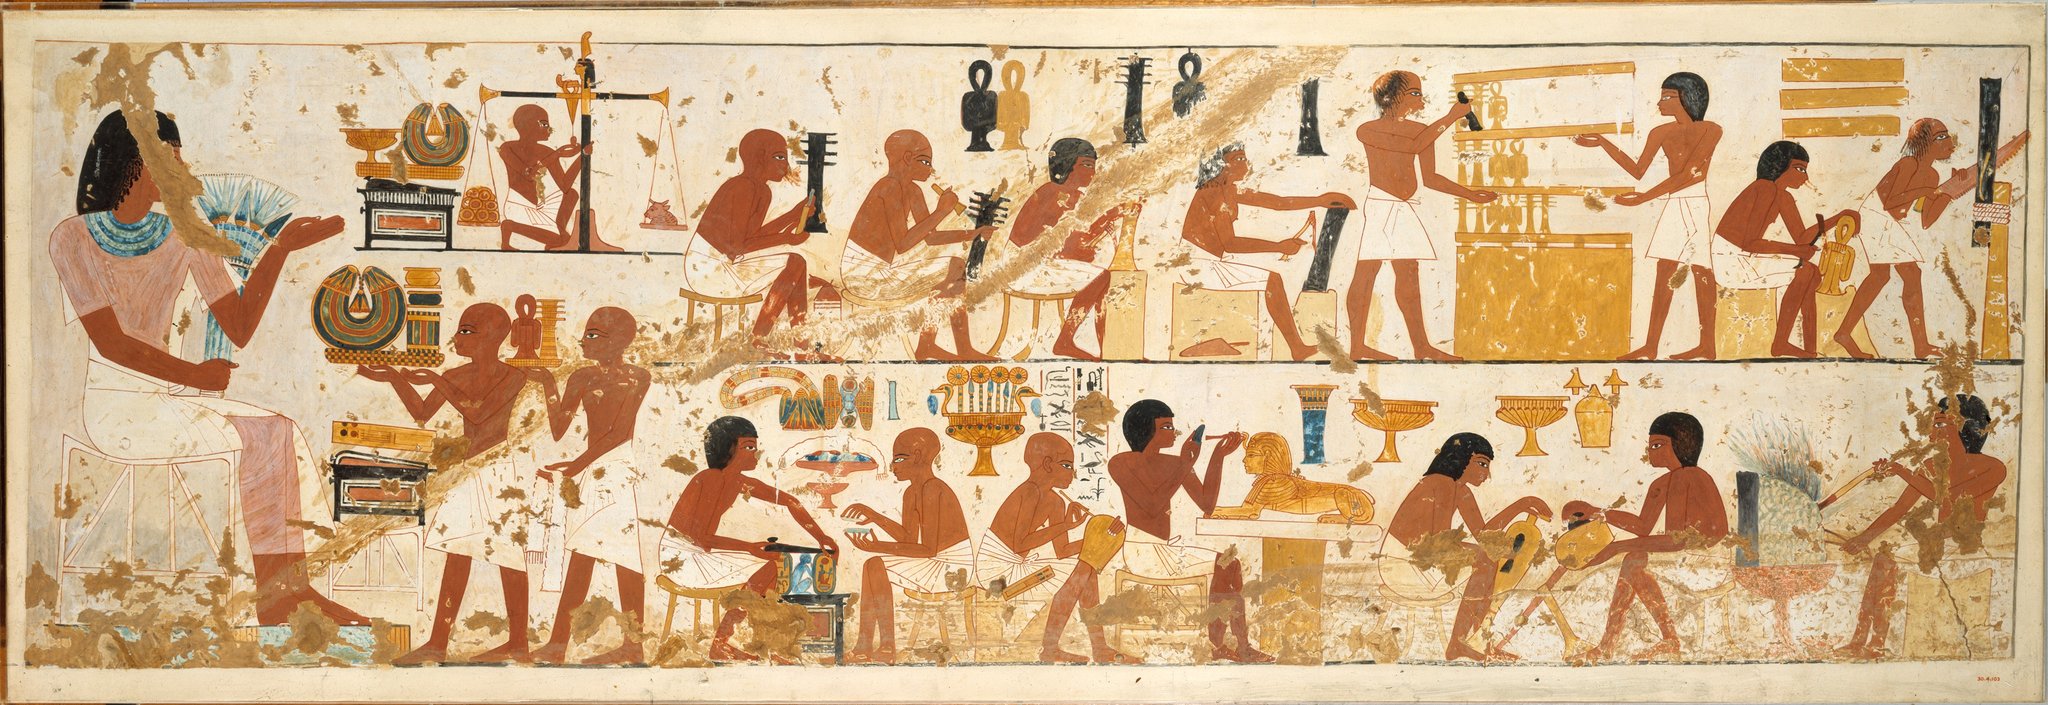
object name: facsimile, nebamun tt 181, ipuky, jeweler, carpenter, metal worker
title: Craftsmen, Tomb of Nebamun and Ipuky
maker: norman de garis davies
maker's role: artist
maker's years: 1865-1941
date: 1390-1349 BCE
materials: paper, paint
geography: egypt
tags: men,working